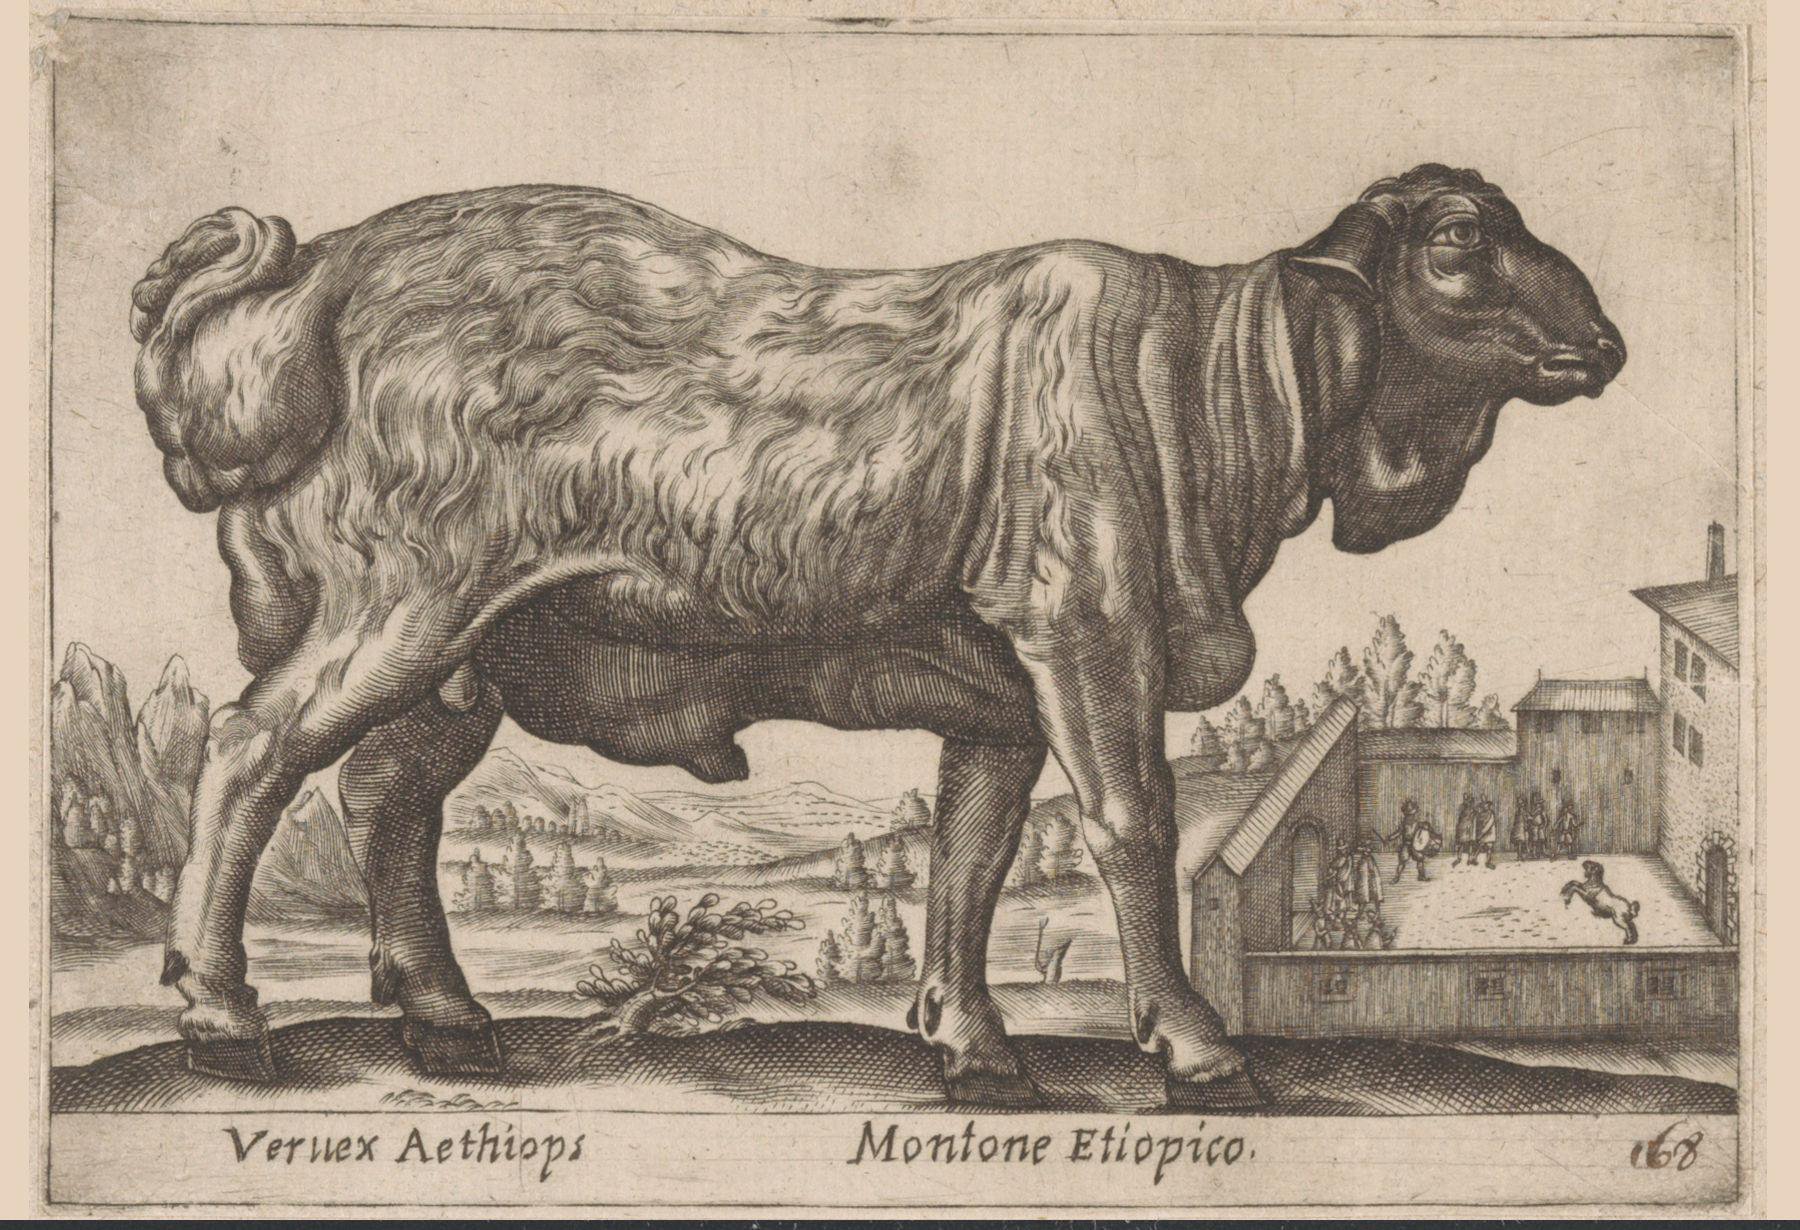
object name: print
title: Nova raccolta de li animali piu curiosi del mondo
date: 1565-1630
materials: paper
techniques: etching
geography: vatican city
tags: sheep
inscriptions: collector's mark: Lugt 11, number: ‘168’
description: Deze prent maakt deel uit van een reeks prenten van dieren door Antonio Tempesta. Bekend is dat een tweede staat (met nummering) van deze serie is uitgegeven door Giovanni Giacomo de' Rossi in 1650. Onbekend is wie de eerste staat heeft uitgegeven en wanneer.